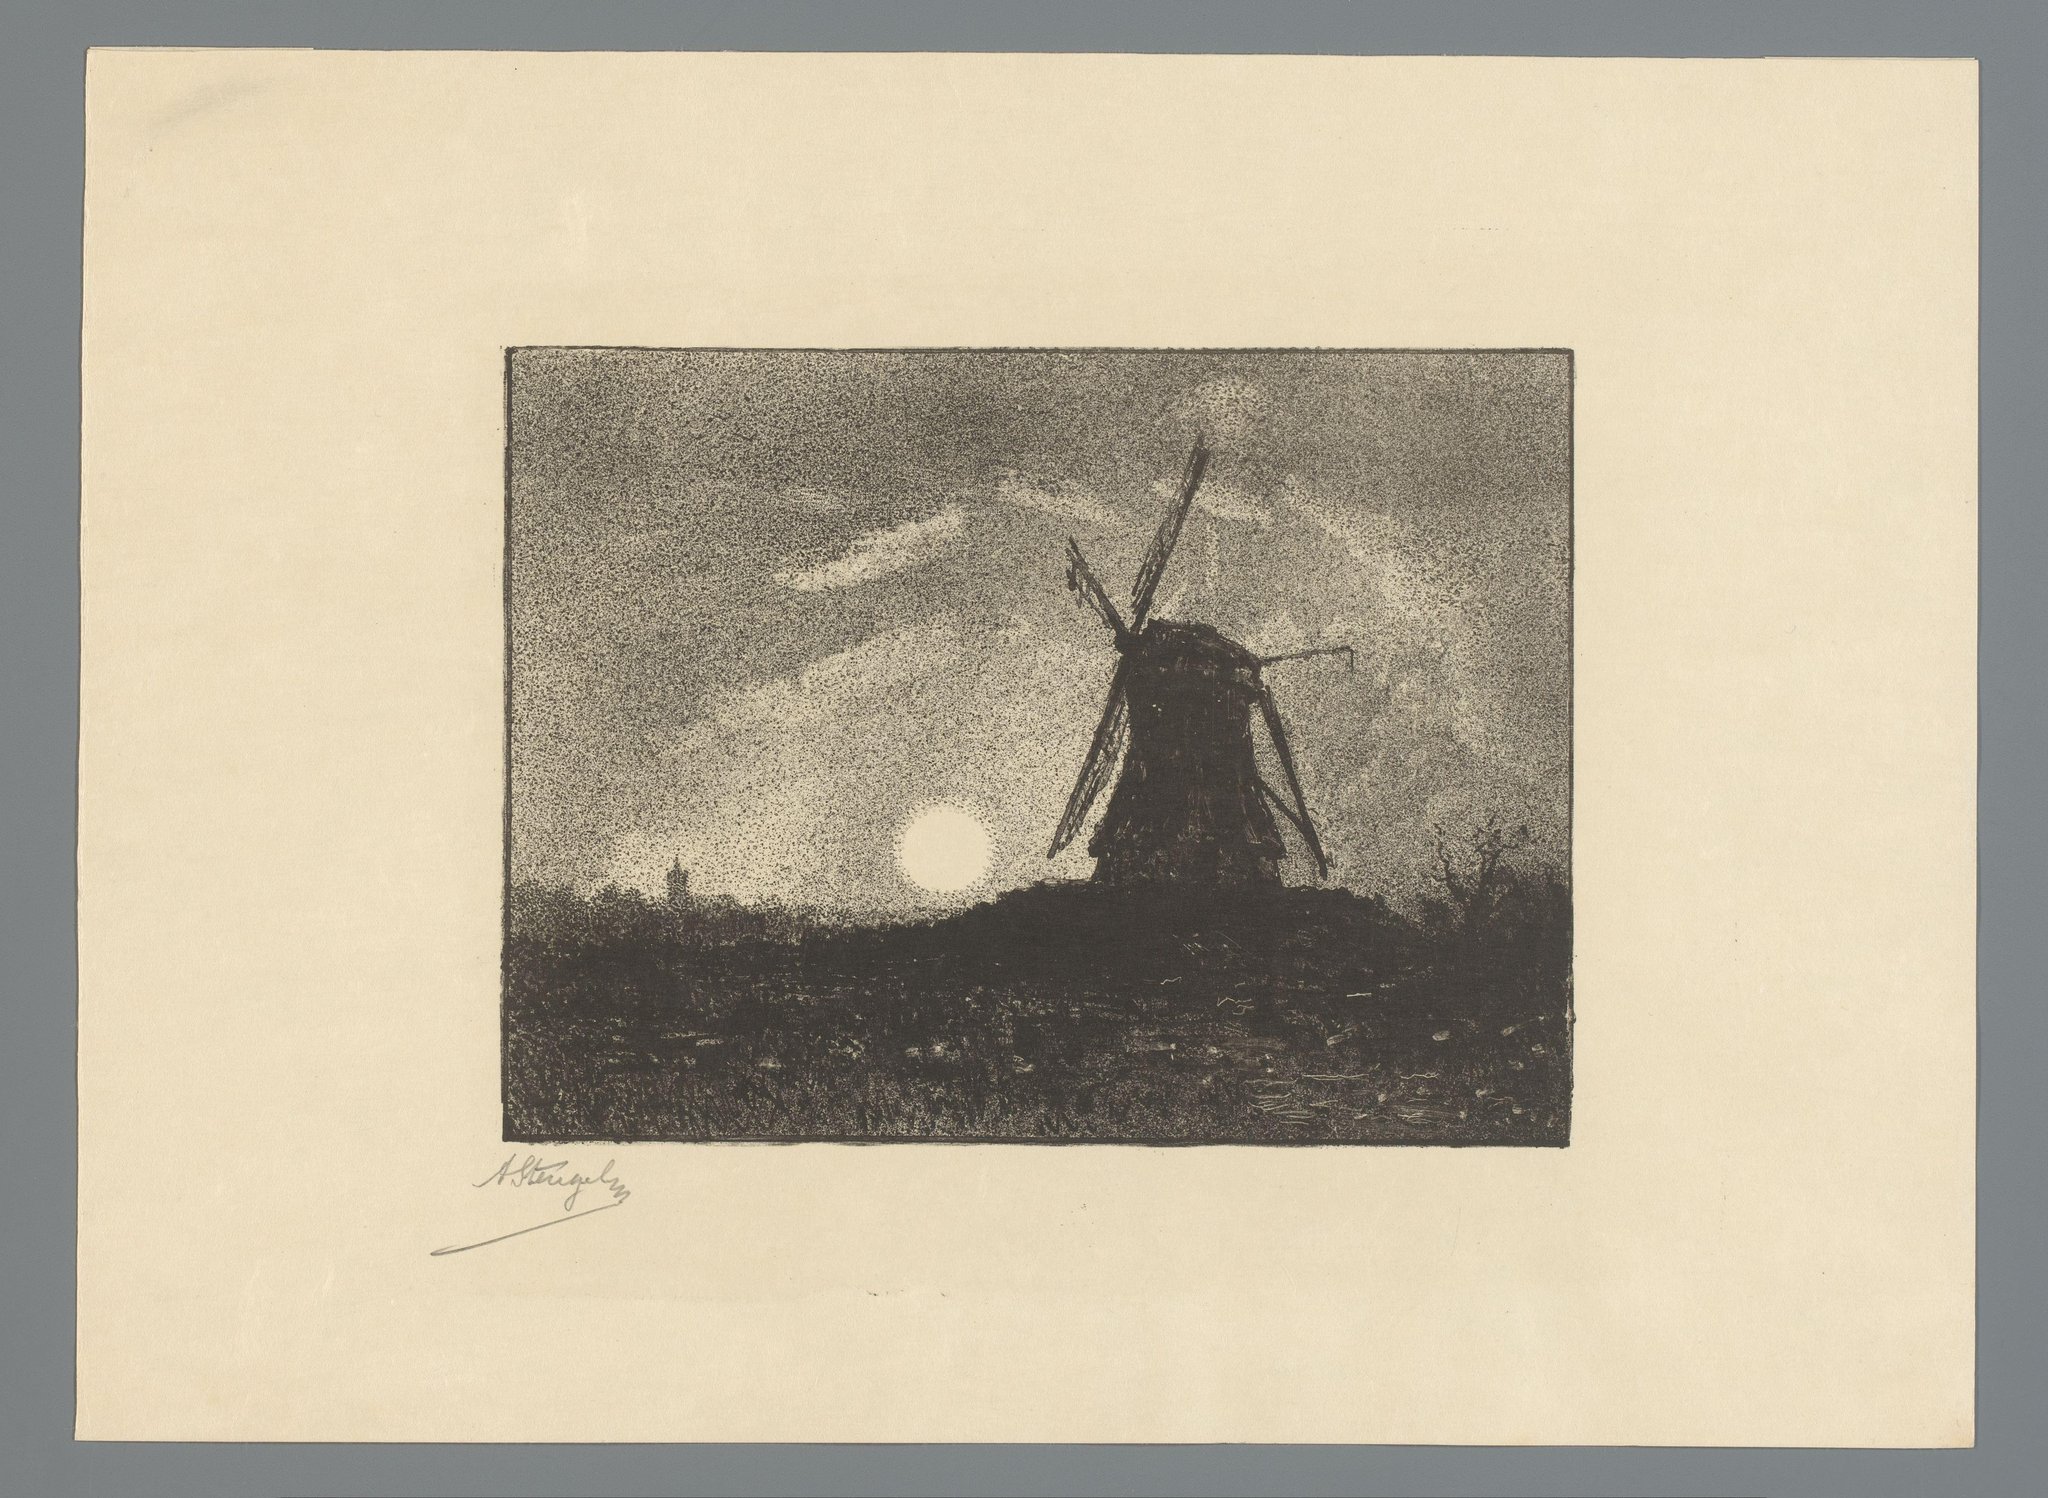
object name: print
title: Lune et moulin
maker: alphonse stengelin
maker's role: painter, print maker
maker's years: 1852-1938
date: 1876-1910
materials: paper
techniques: lithograph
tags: full moon, windmill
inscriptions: collector's mark: Lugt 2228